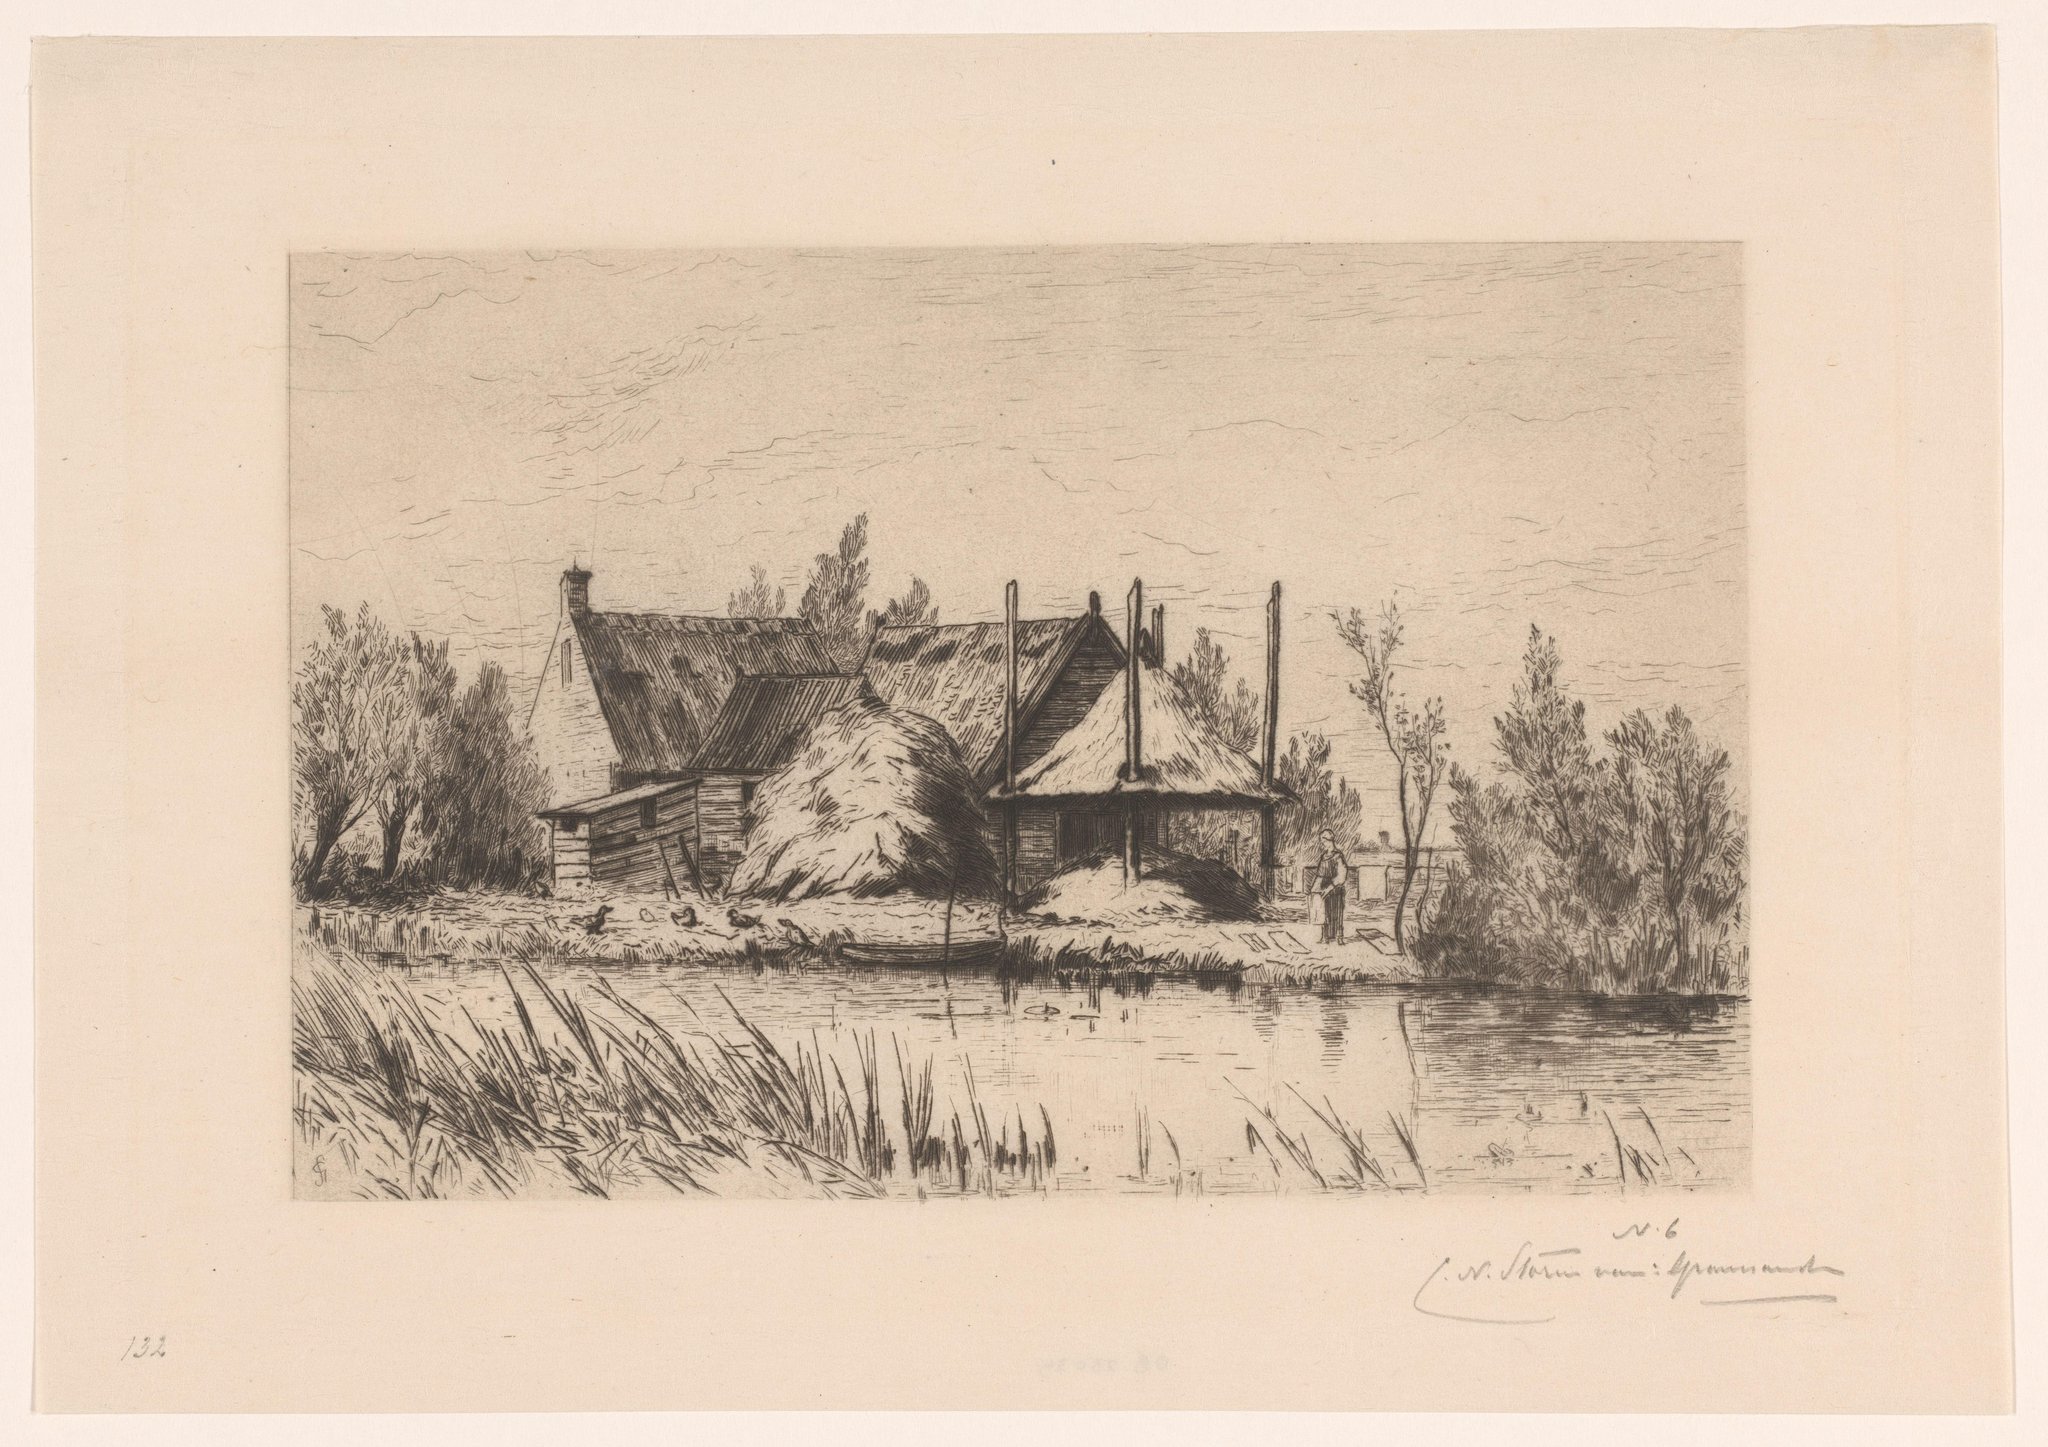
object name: print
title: Ferme près d'Abconde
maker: carel nicolaas storm van s-gravesande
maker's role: draughtsman, print maker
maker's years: 1841-1924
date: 1880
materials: paper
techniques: drypoint, etching, intaglio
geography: netherlands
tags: hay-stack, farm or solitary house in landscape (+ city(-scape) with figures, staffage), abcoude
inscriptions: number: ‘N. 6’, collector's mark: Lugt 2228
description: Gezicht op een boerderij met een hooiberg. Rechts staat een vrouw de was te doen.